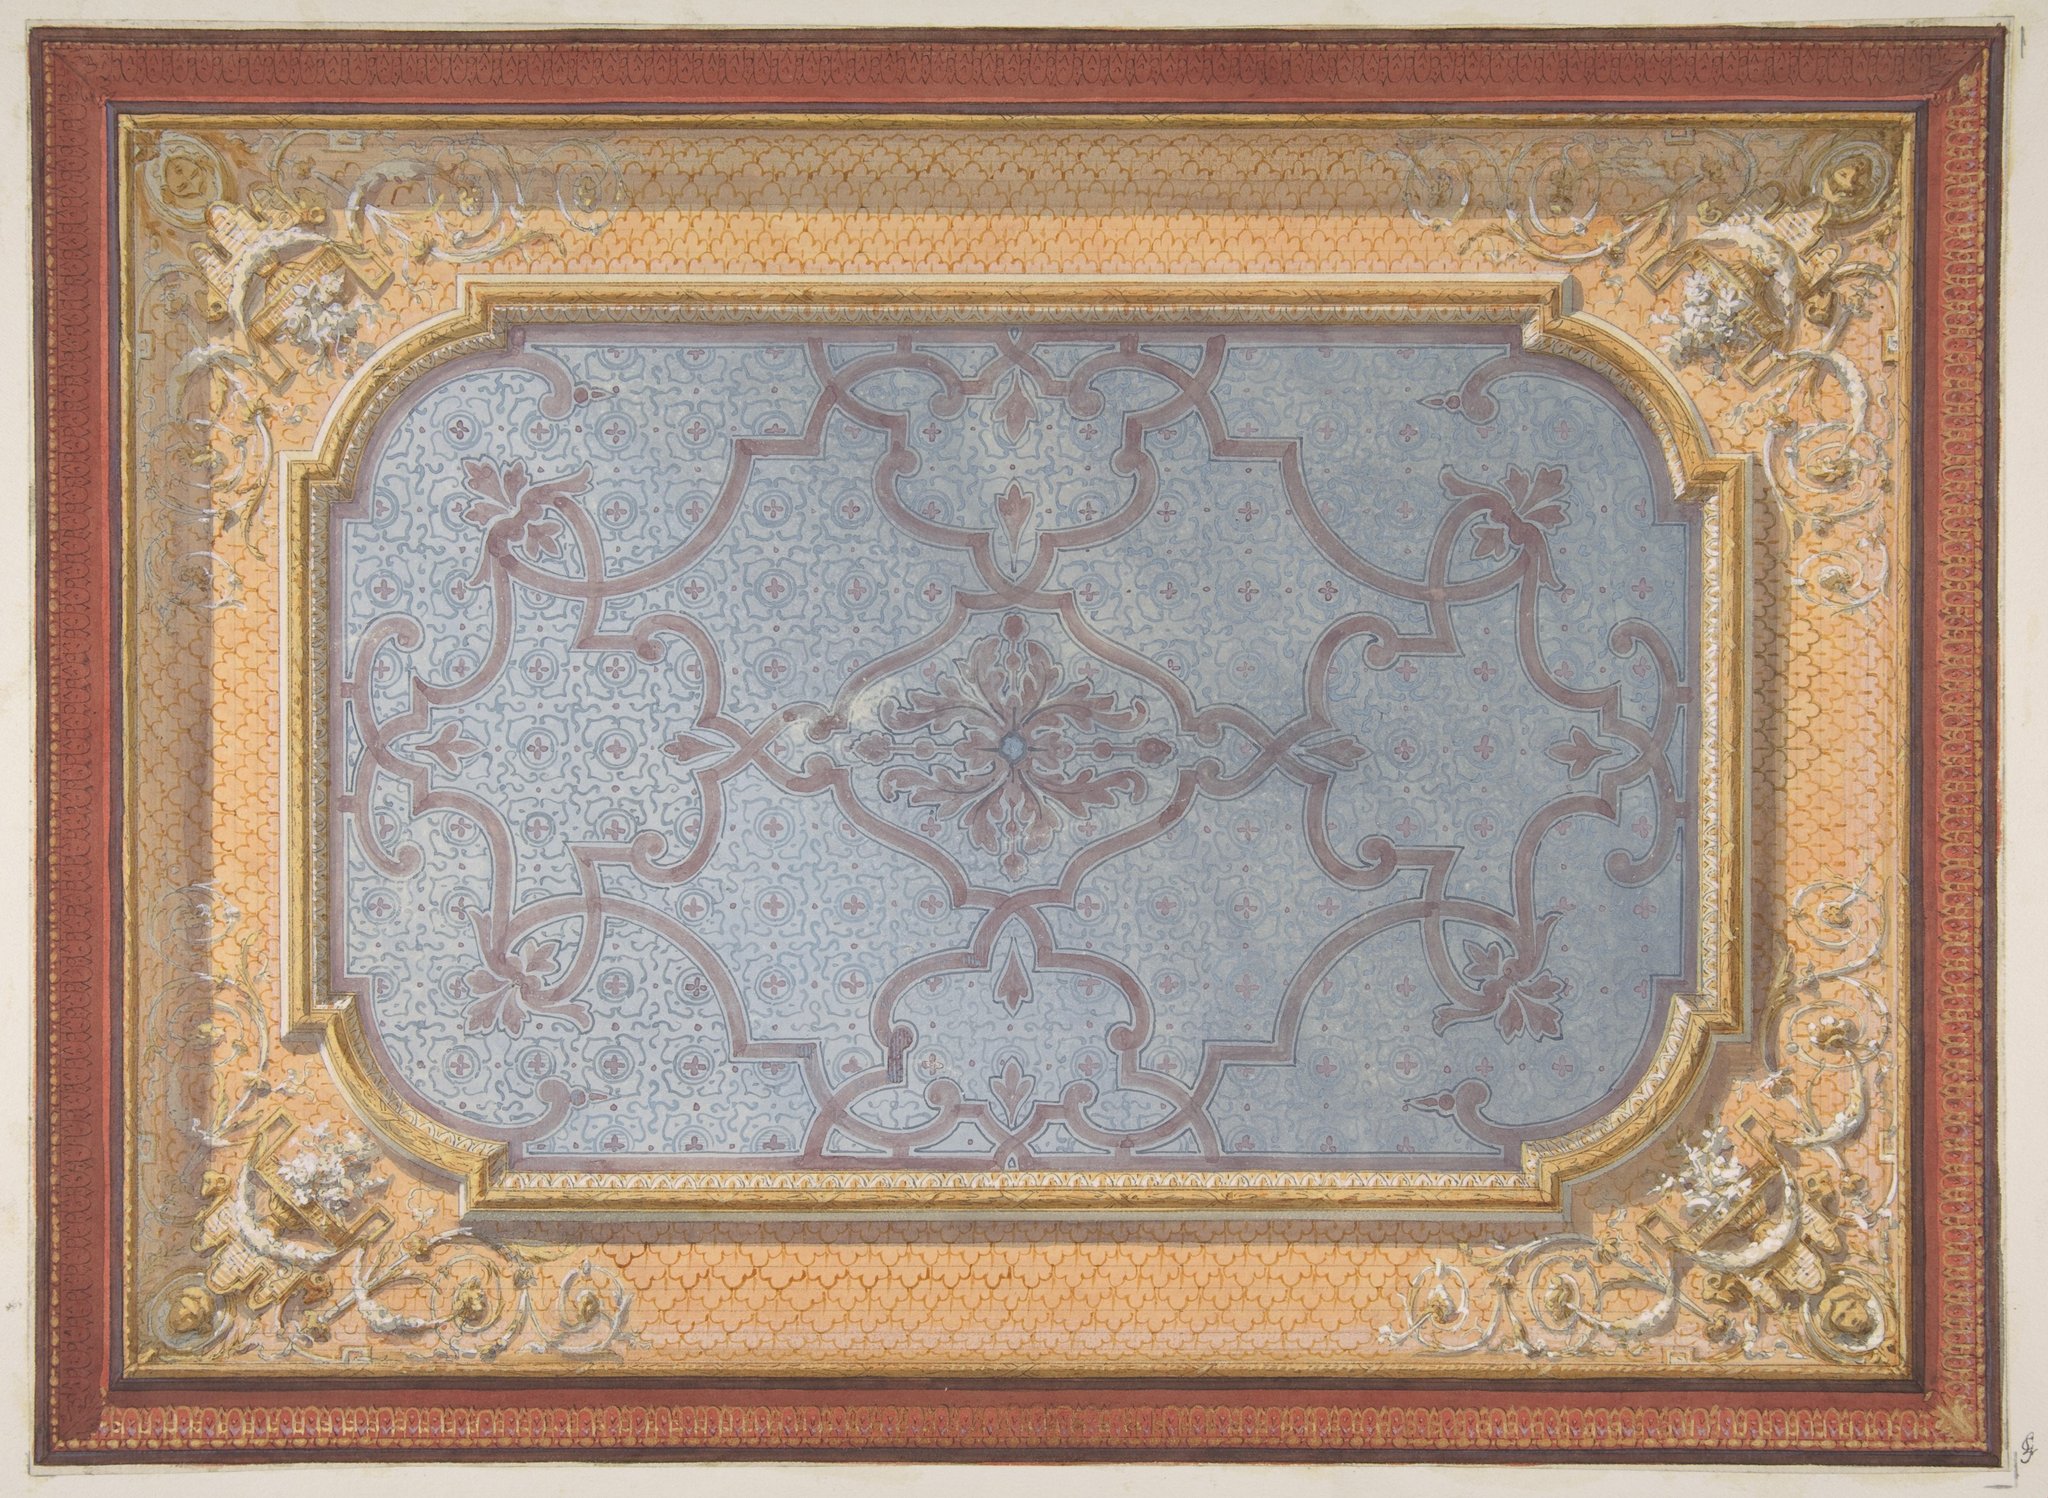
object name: drawing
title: Design for the decoration of a ceiling with urns, swags, and portrait medallions in the four corners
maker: jules-edmond-charles lachaise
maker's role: artist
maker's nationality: french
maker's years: 1897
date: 1830-1897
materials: ink, watercolor, paper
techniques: pen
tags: ceilings